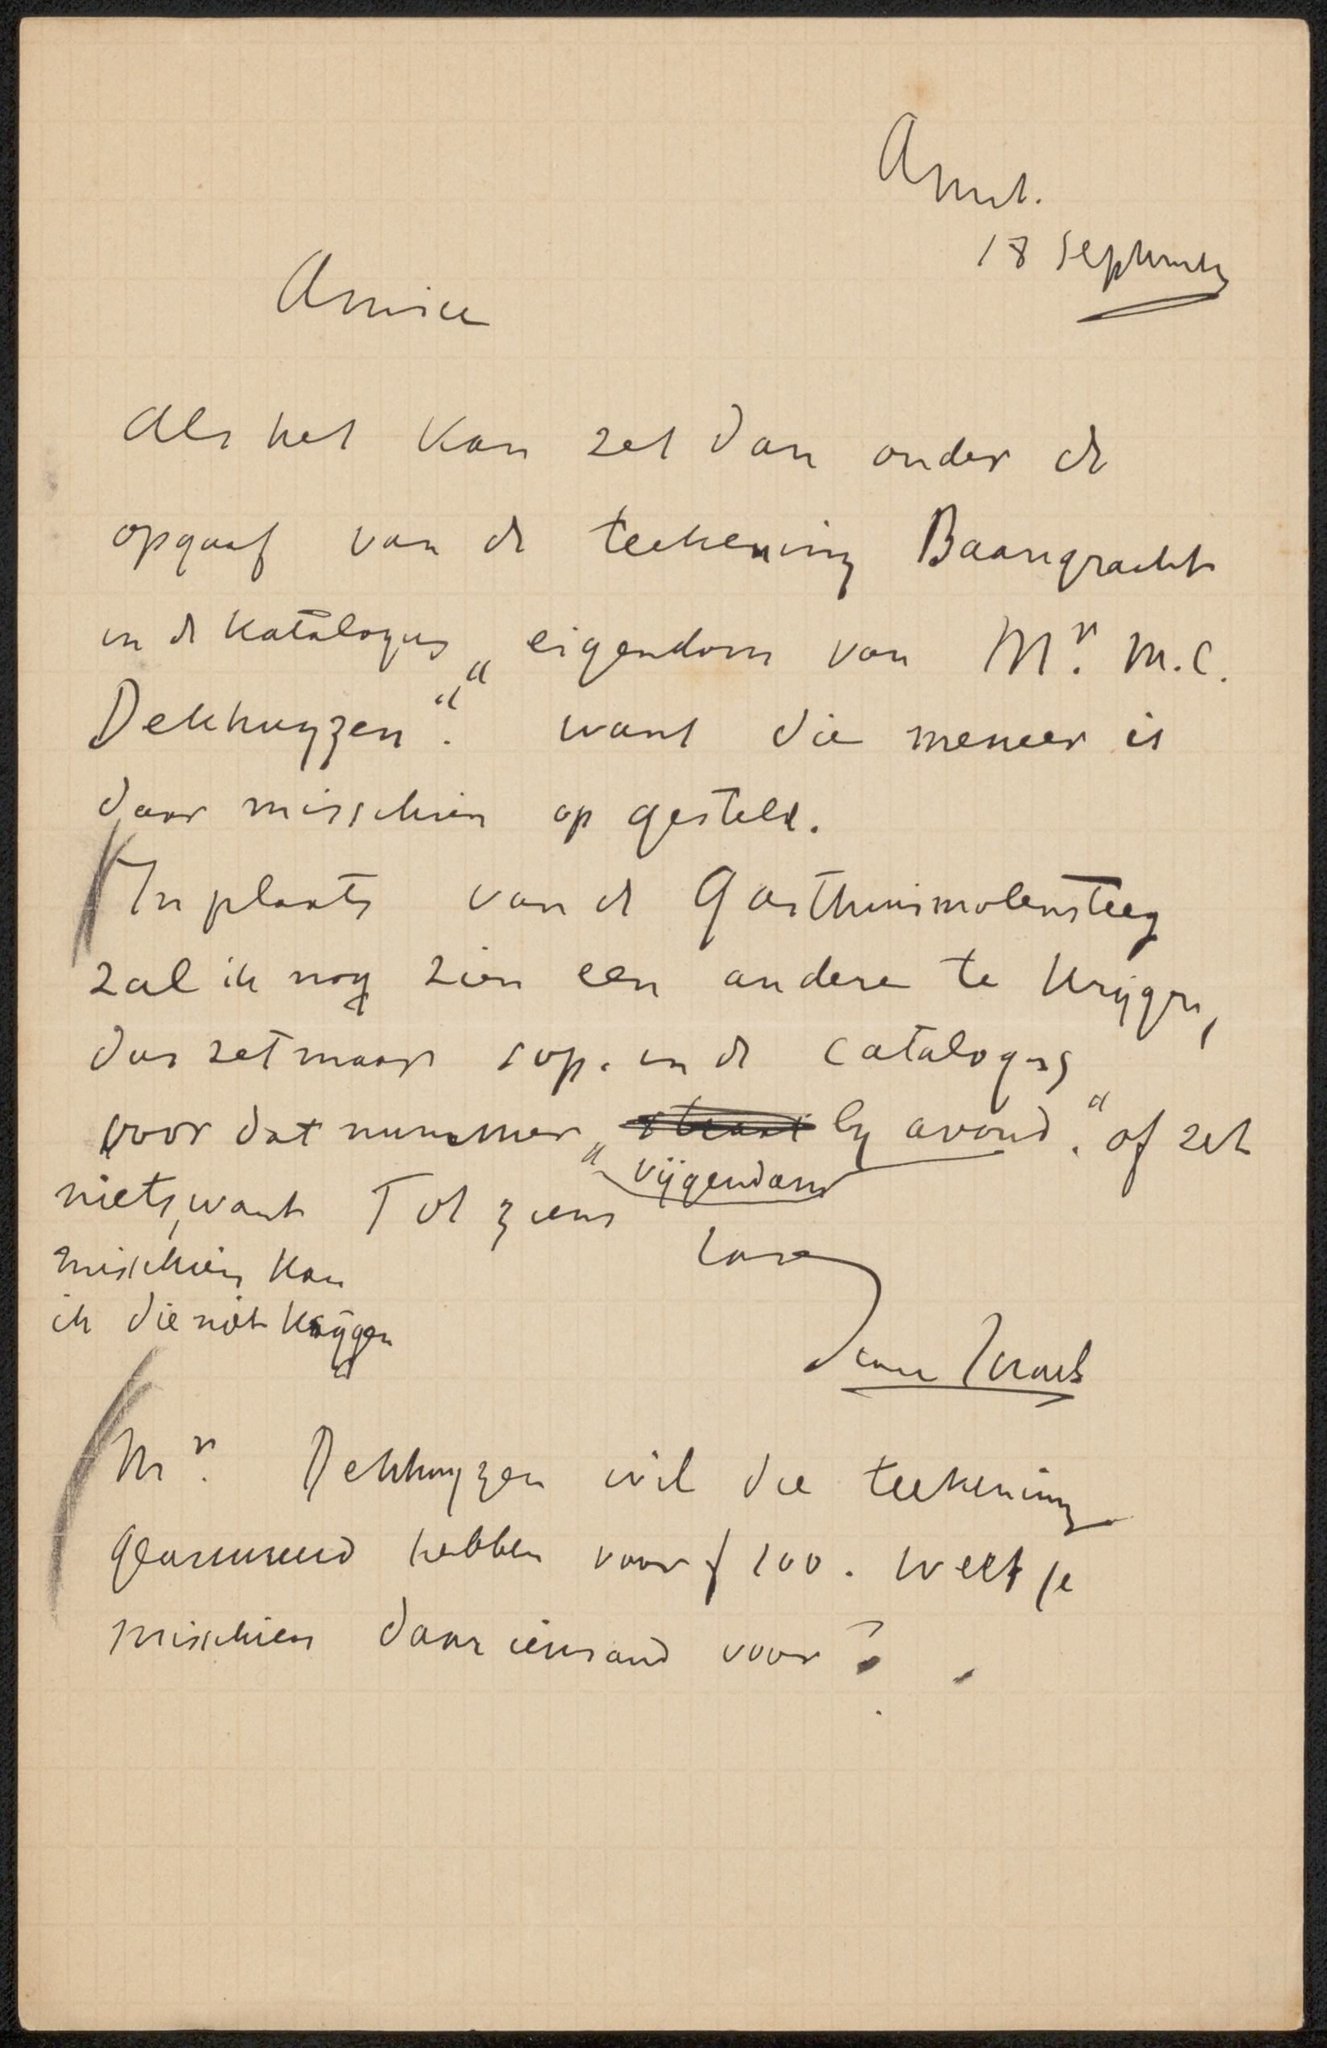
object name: letter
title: Brief aan Philip Zilcken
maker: isaac israels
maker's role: draughtsman, painter, print maker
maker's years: 1865-1934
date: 1875-1930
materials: ink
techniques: writing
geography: amsterdam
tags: the hague, painter, draughtsman, philip zilcken, drawing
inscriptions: collector's mark: ‘RPK’